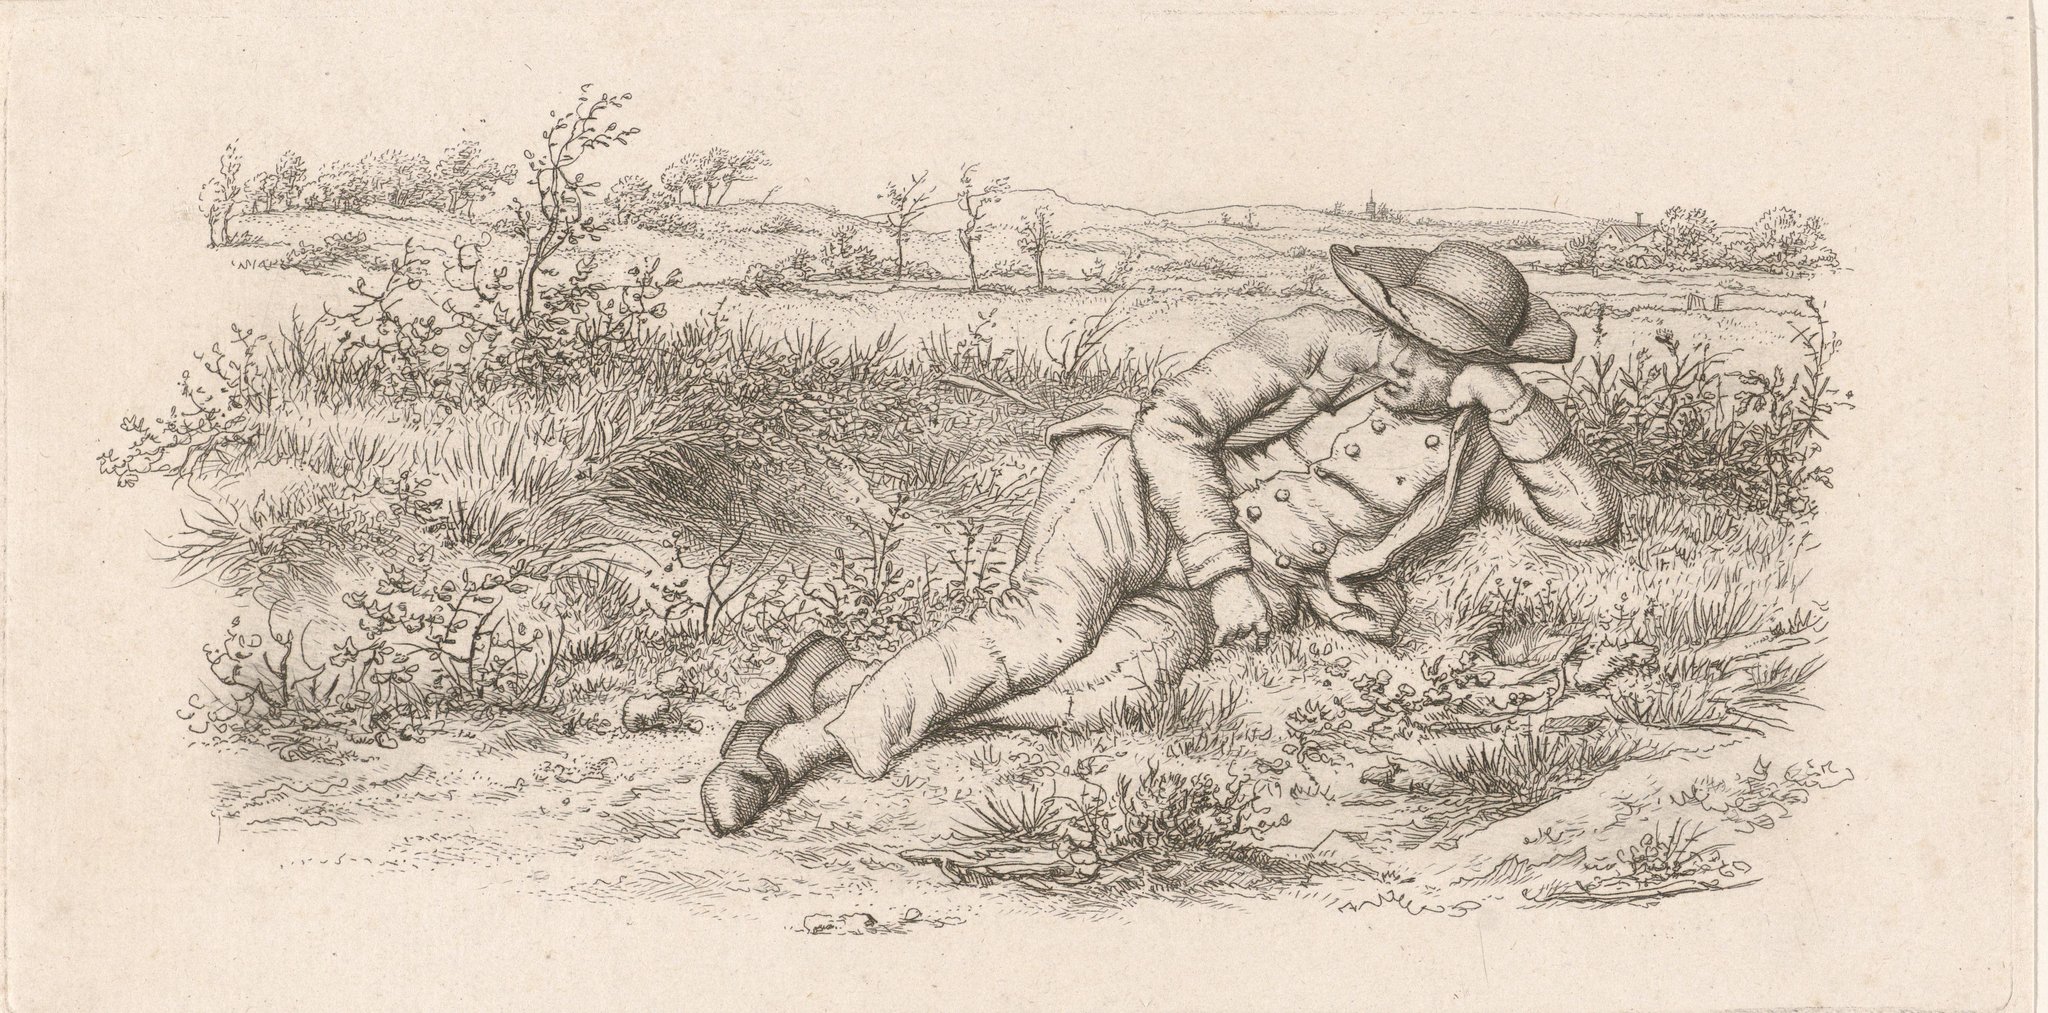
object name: print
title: Liggende man in een landschap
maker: jacob ernst marcus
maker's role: draughtsman, print maker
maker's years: 1774-1826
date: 1811-1813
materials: paper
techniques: etching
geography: amsterdam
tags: lying on one side, with uplifted upper part of the body and leaning on the arm, resting - bb - out of doors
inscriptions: collector's mark: Lugt 2228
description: Serie voor het eerst uitgegeven door Jacob Ernst Marcus onder de titel Studiebeelden en Fragmenten. Amsterdam: ca.1816. Later heruitgegeven als: Studie-prentwerk/ Etudes gravées.